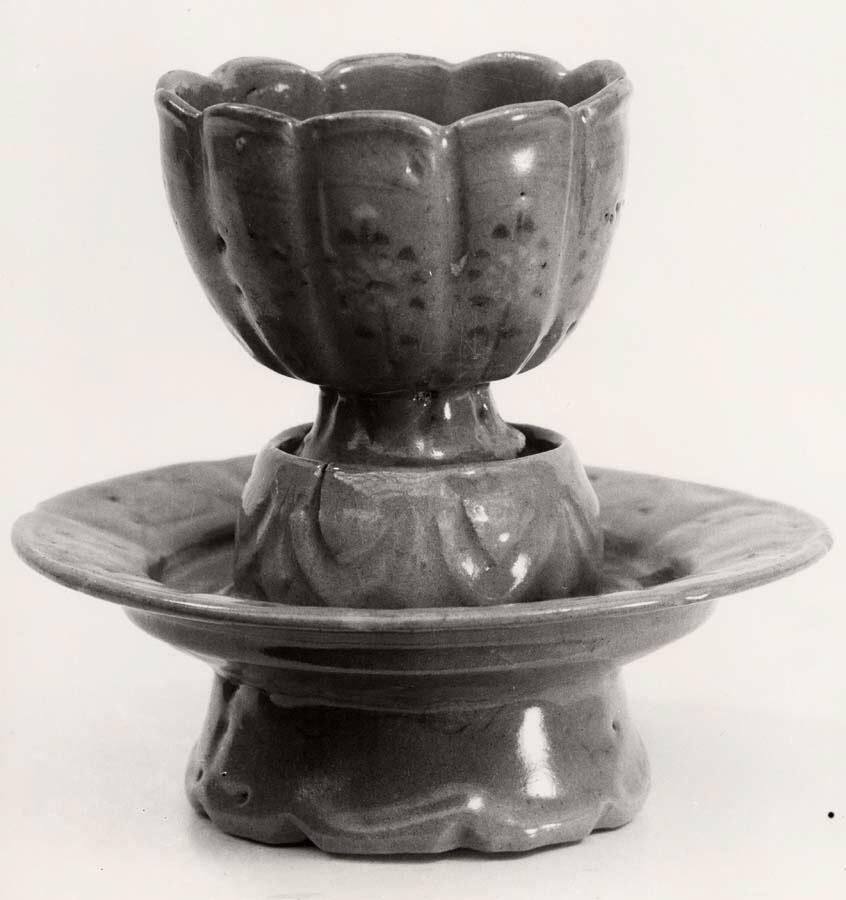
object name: cup stand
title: Cup with Stand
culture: korean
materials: clay